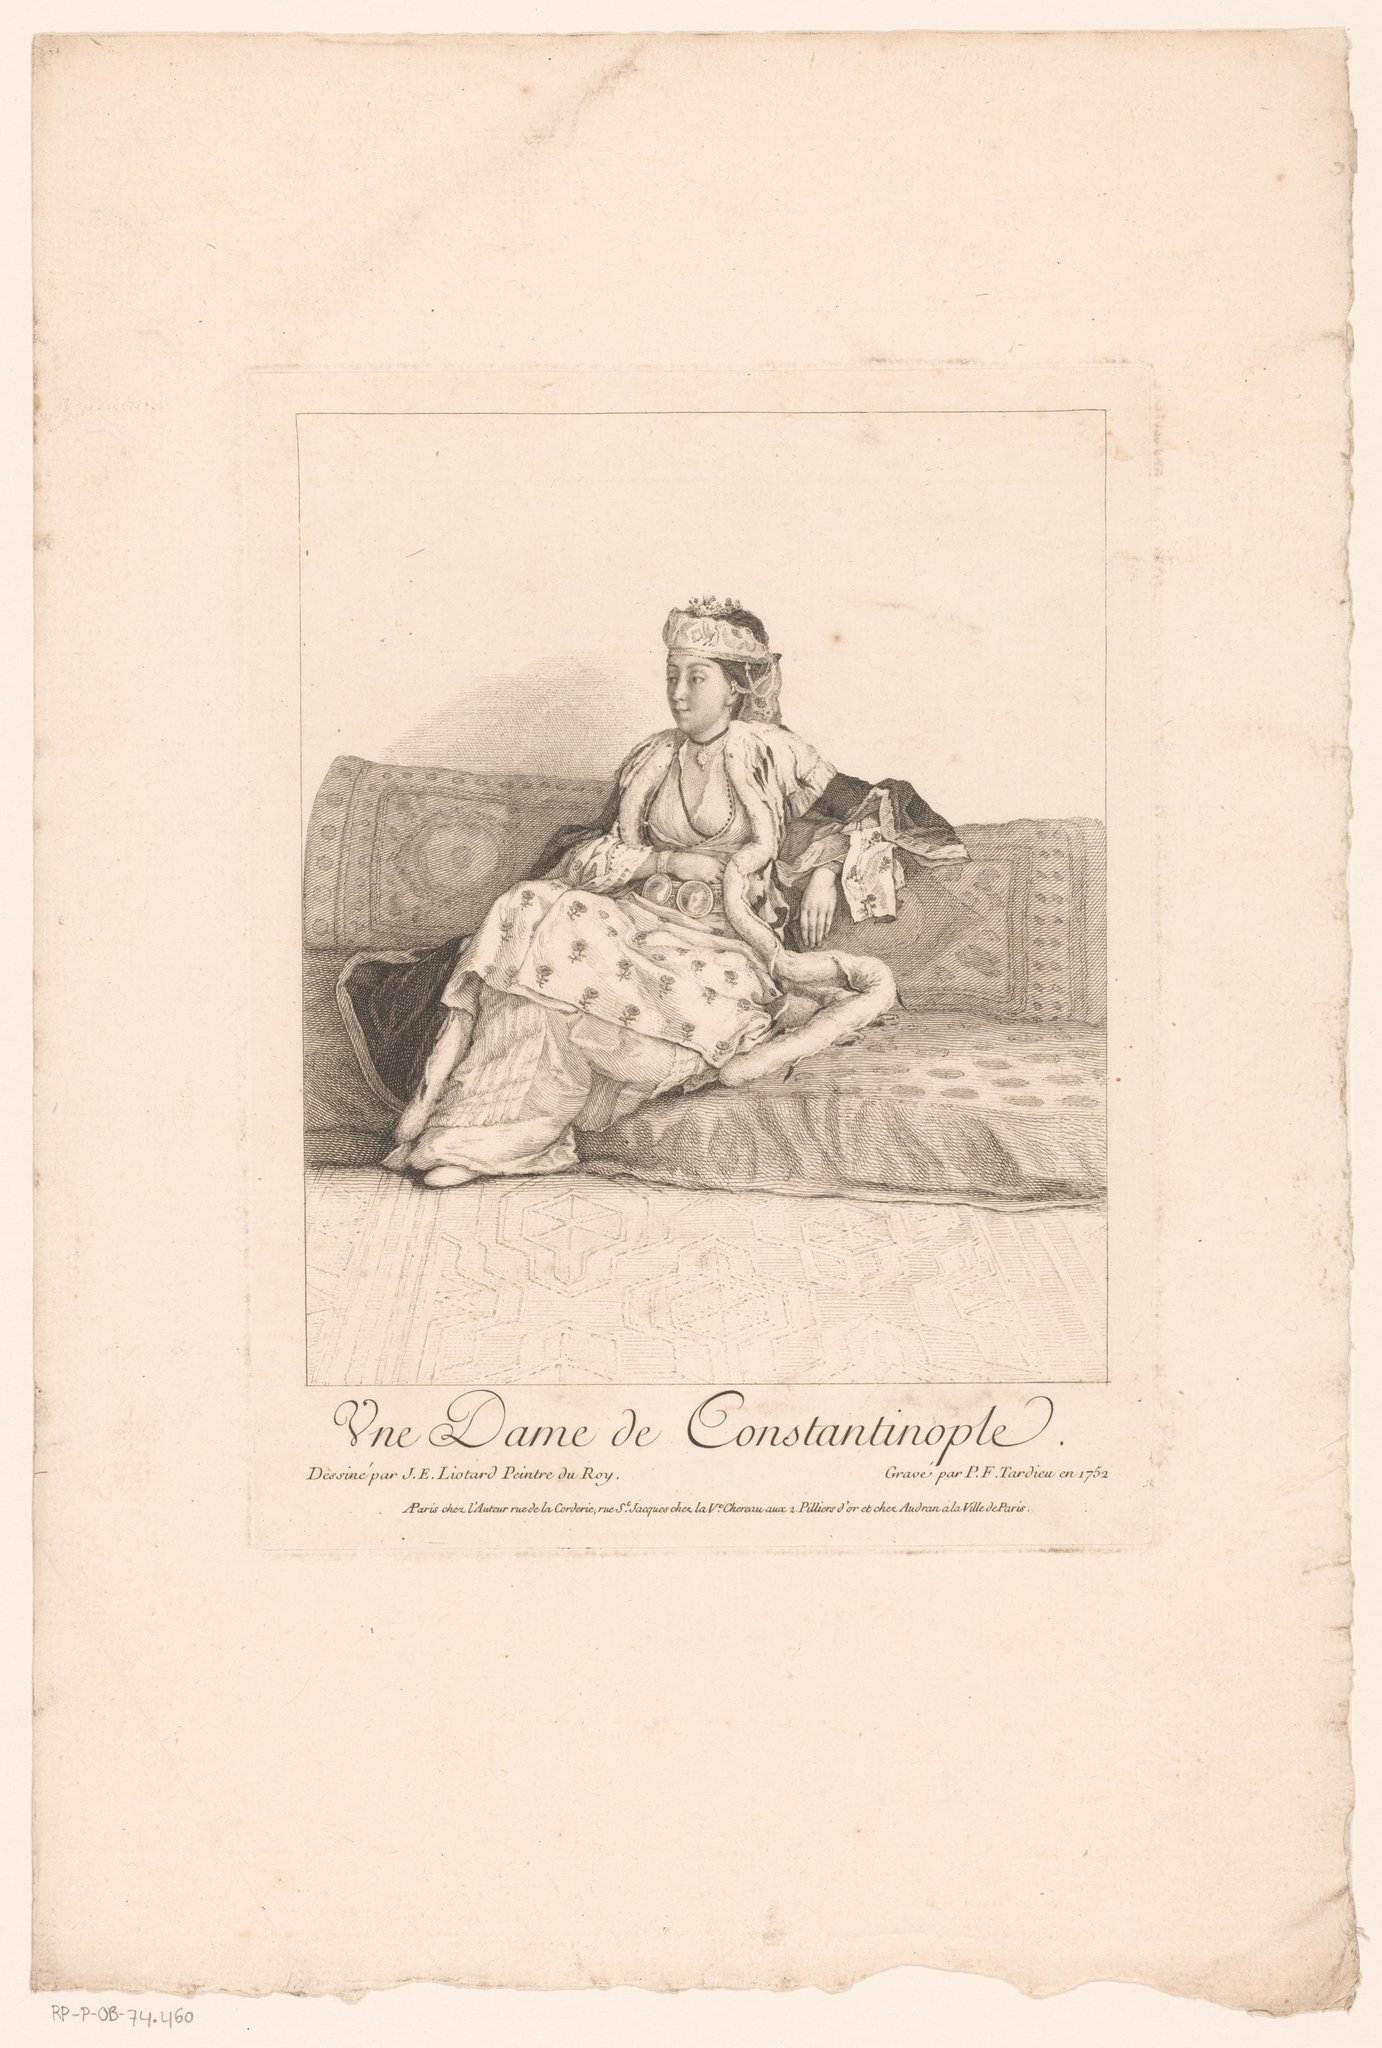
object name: print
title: Une dame de Constantinople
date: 1752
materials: paper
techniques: engraving, etching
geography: paris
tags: asiatic races and peoples: turks (+ costume)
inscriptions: collector's mark: Lugt 2228